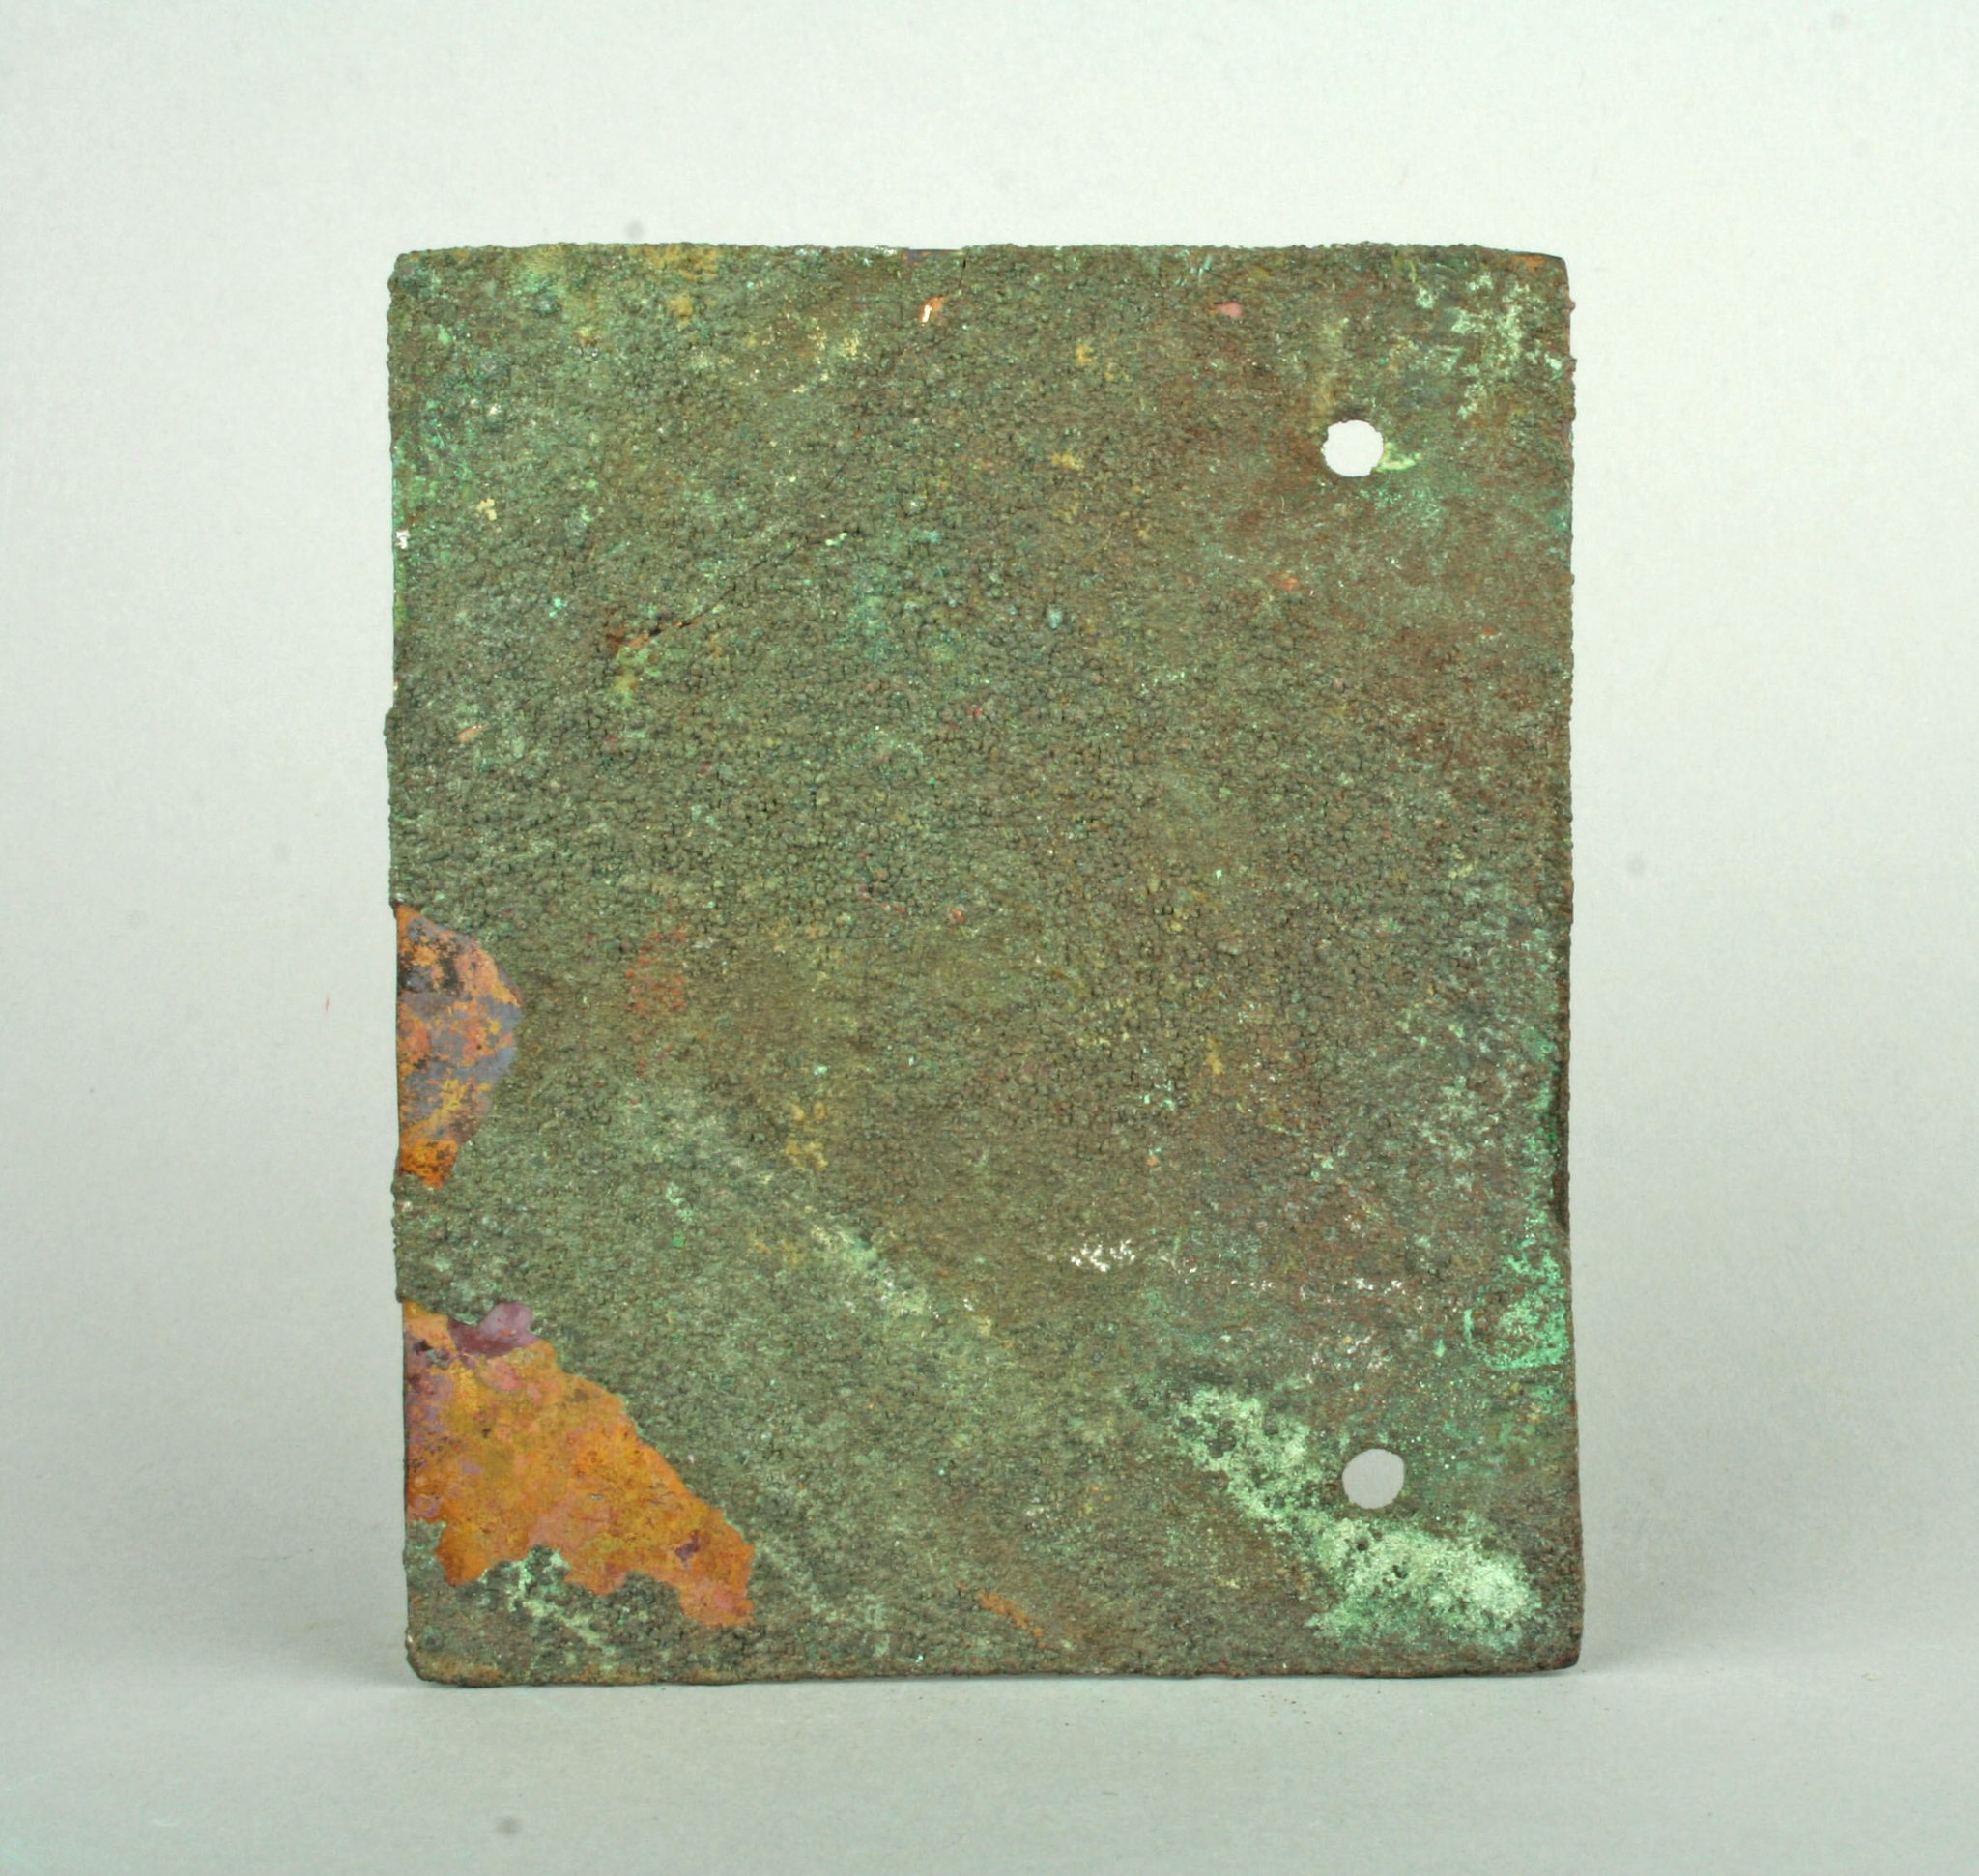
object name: plaque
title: Square Plaque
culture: vicús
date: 300 BCE-200 CE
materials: copper, gilt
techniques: hammering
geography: peru